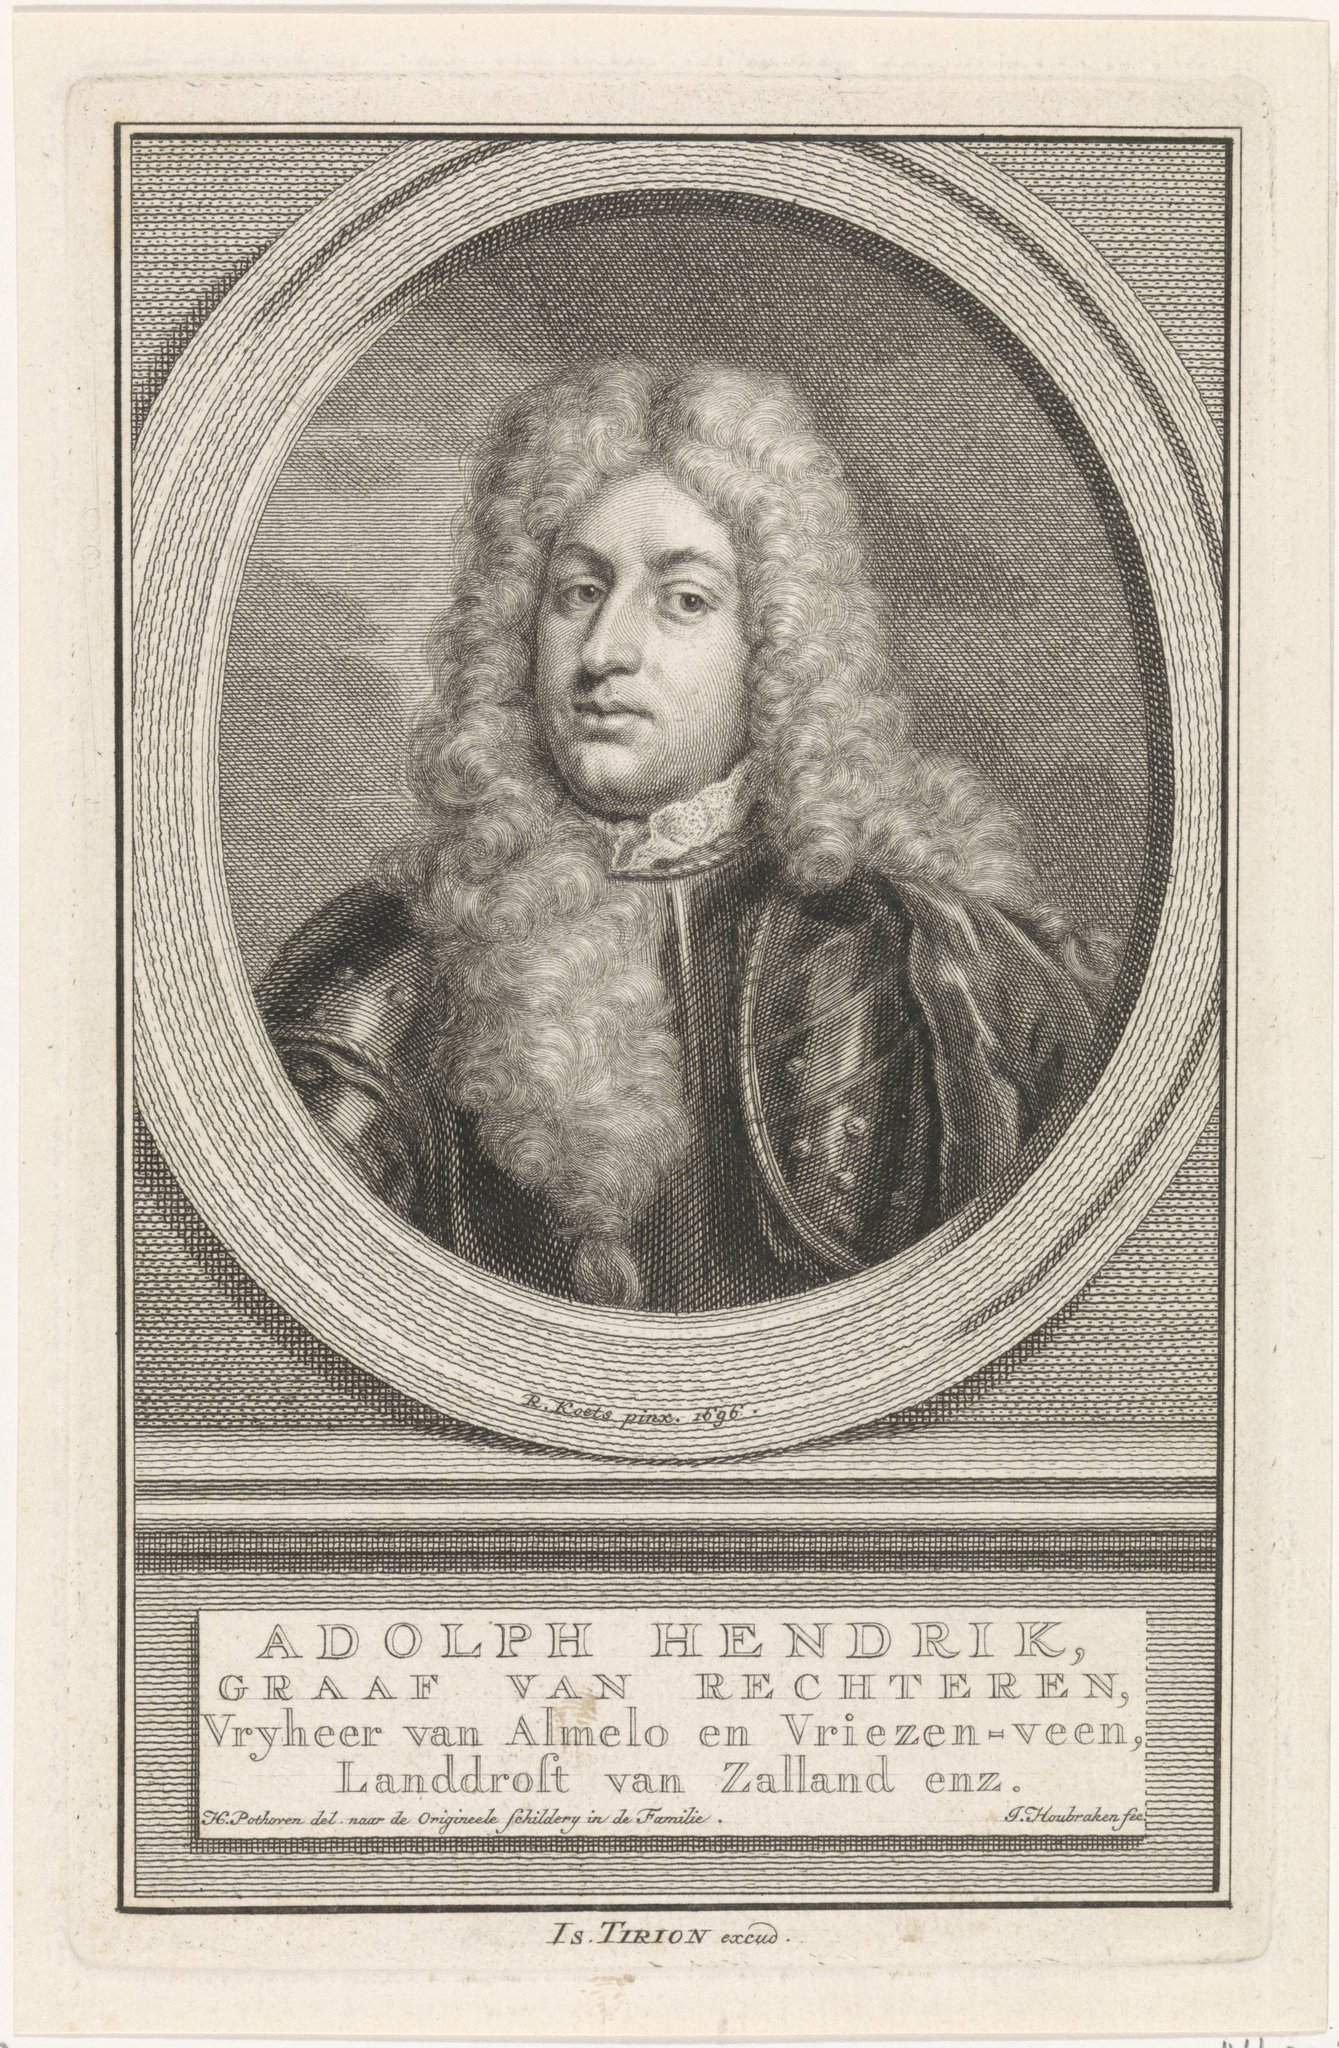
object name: print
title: Adolph Hendrik Graaf van Rechteren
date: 1749-1759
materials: paper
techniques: engraving, etching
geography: amsterdam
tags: zwolle, adolf hendrik van rechteren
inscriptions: collector's mark: Lugt 2228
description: Prent ook gebruikt in: Jan Wagenaar, Vaderlandsche historie, vervattende de geschiedenissen der nu Vereenigde Nederlanden, inzonderheid die van Holland (...), 21 delen. Amsterdam, Isaak Tirion, 1749-59.